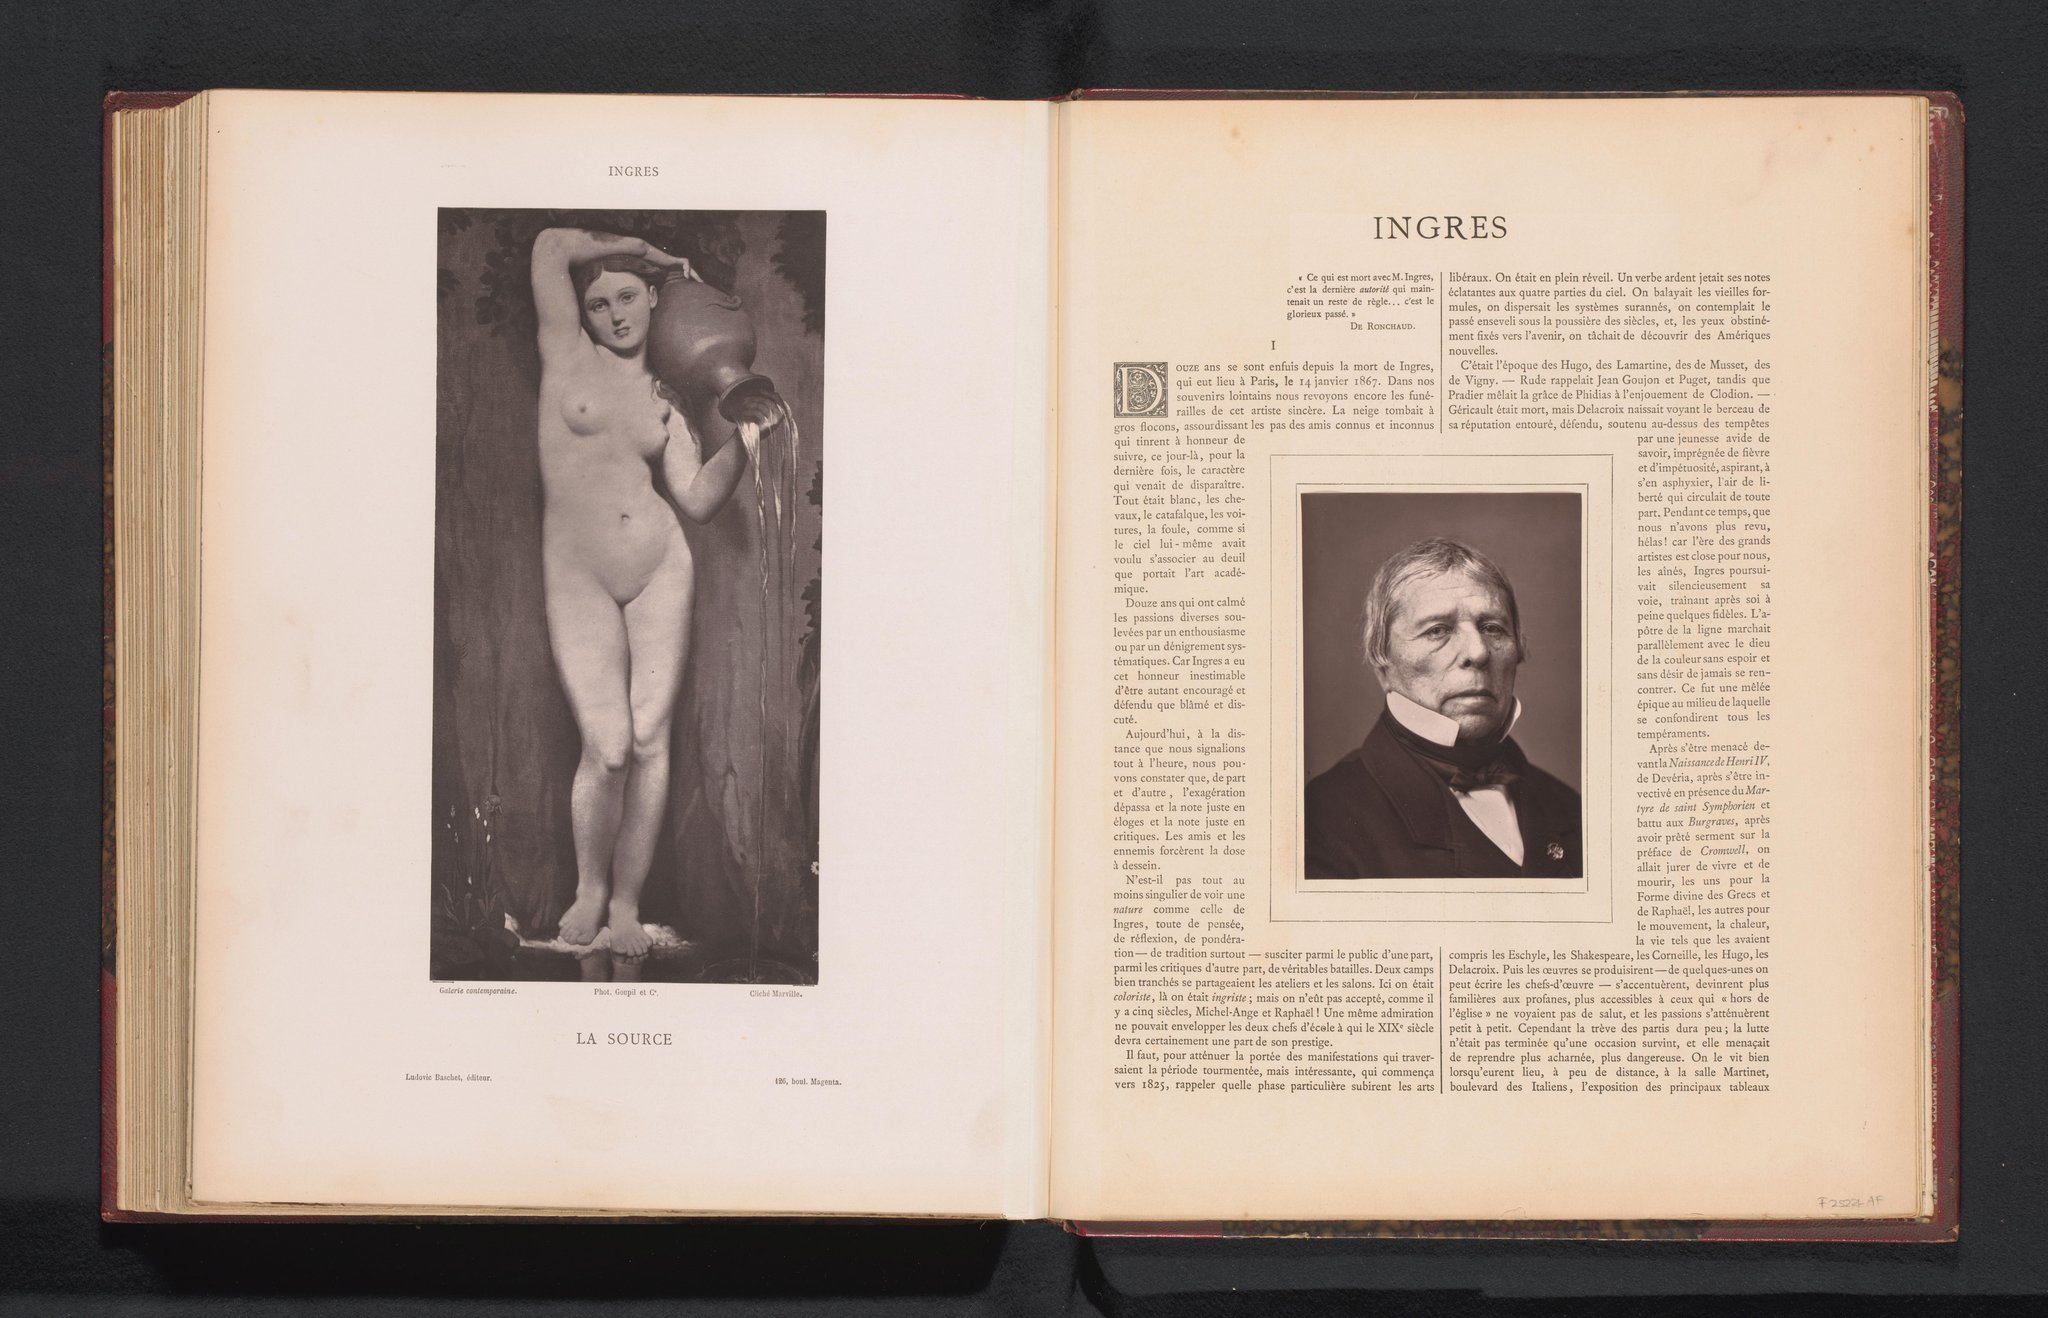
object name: page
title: Portret van Jean Auguste Dominique Ingres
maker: Anonymous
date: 1873-1878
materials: paper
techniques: woodburytype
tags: print maker, jean auguste dominique ingres, adult man, historical persons